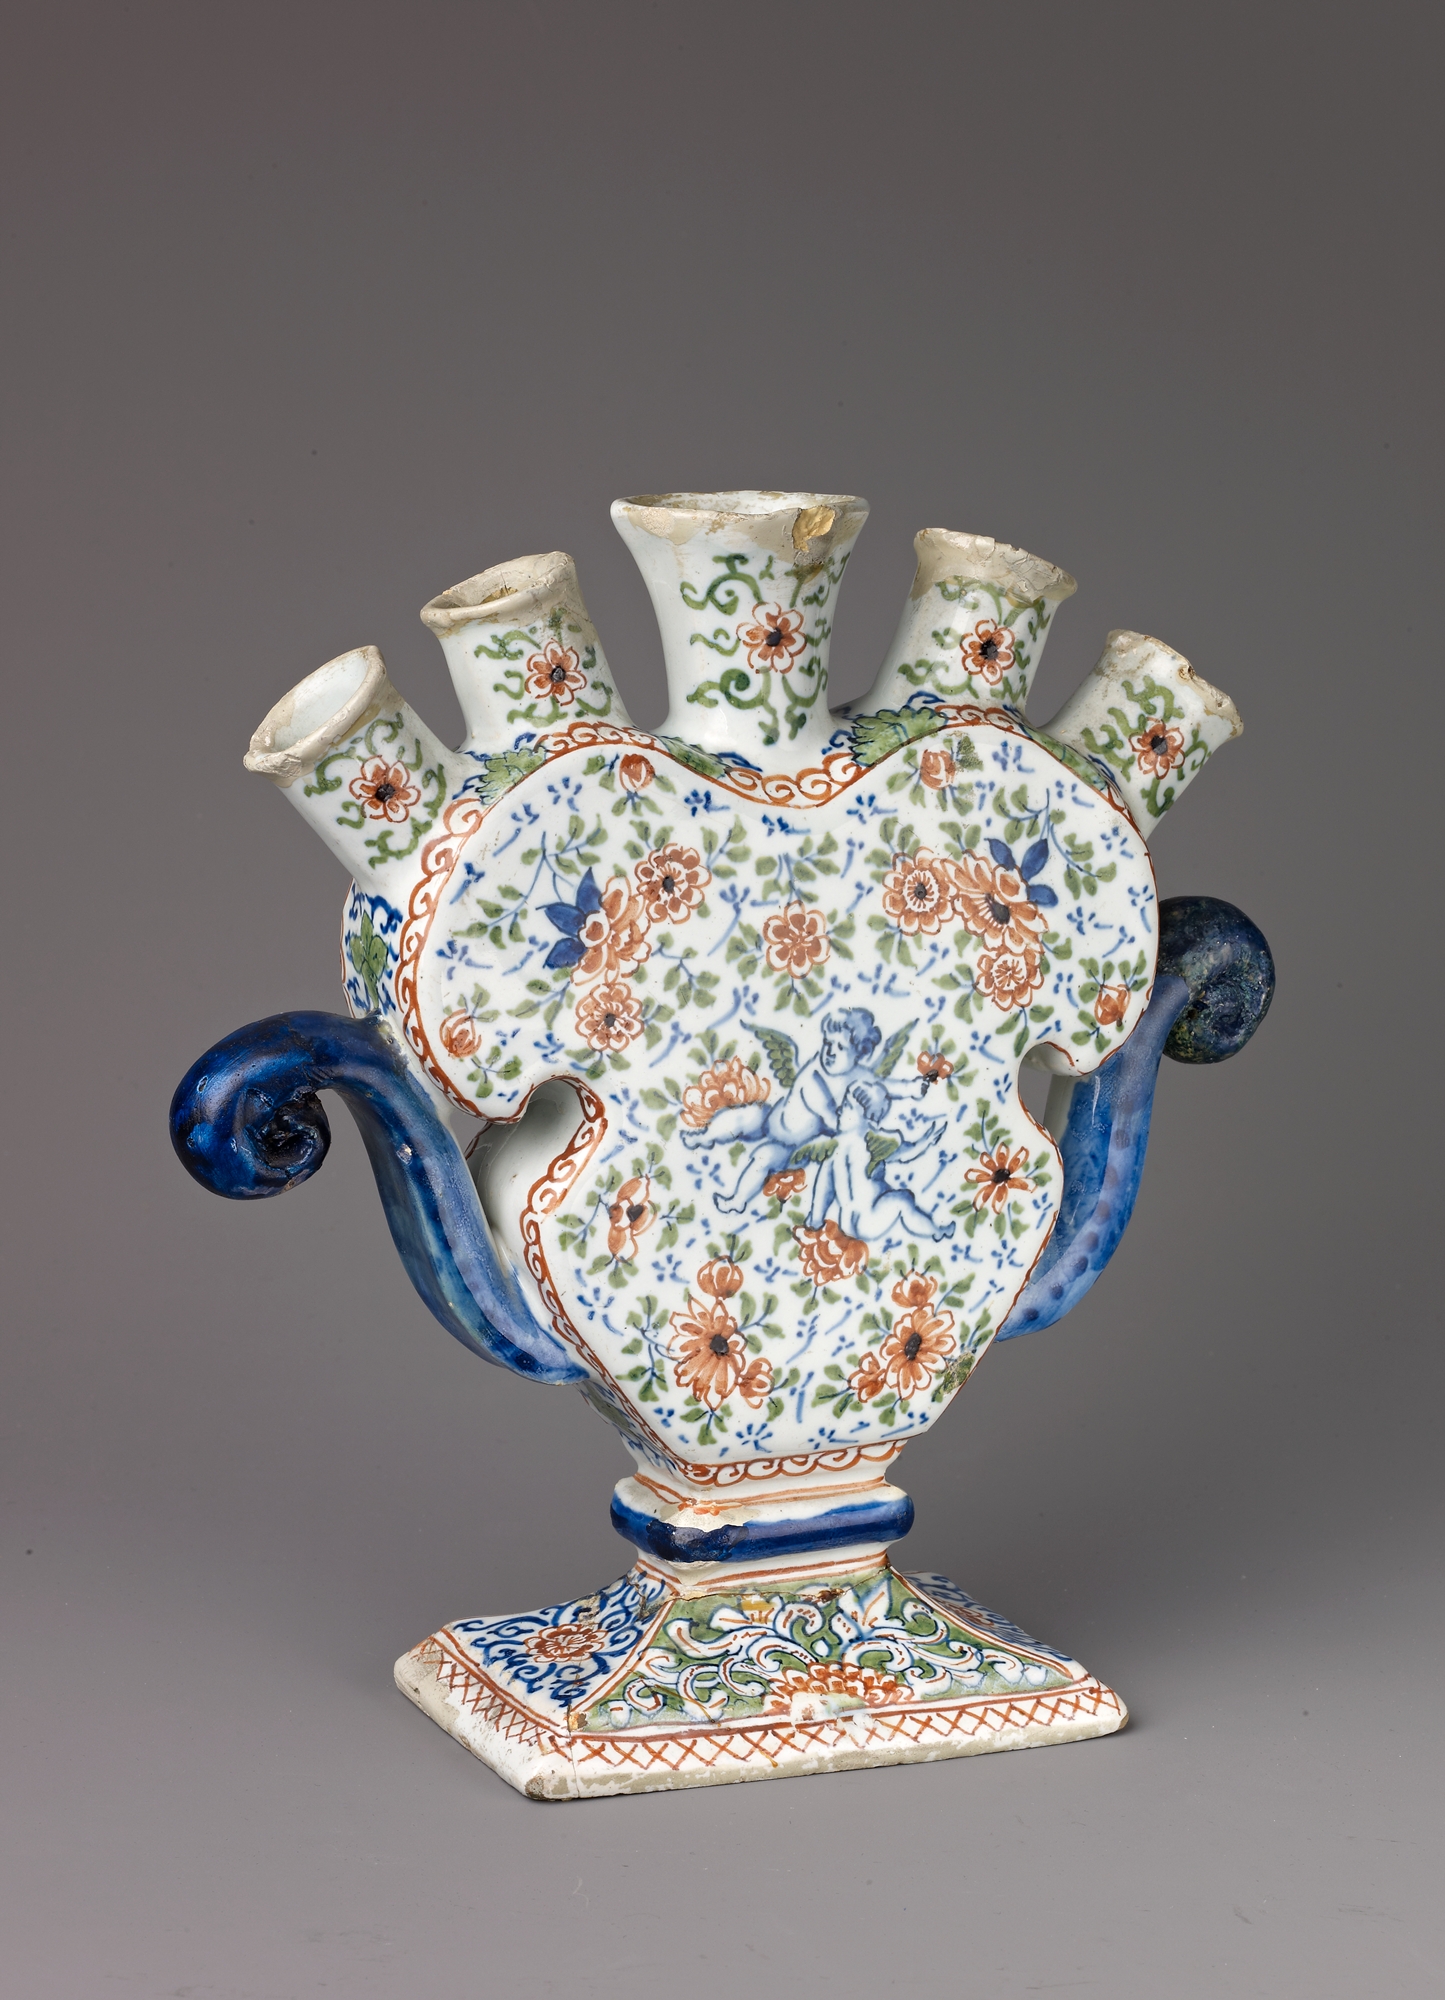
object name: vase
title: Tulip Vase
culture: dutch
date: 1700-1720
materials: earthenware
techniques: glazing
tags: putti